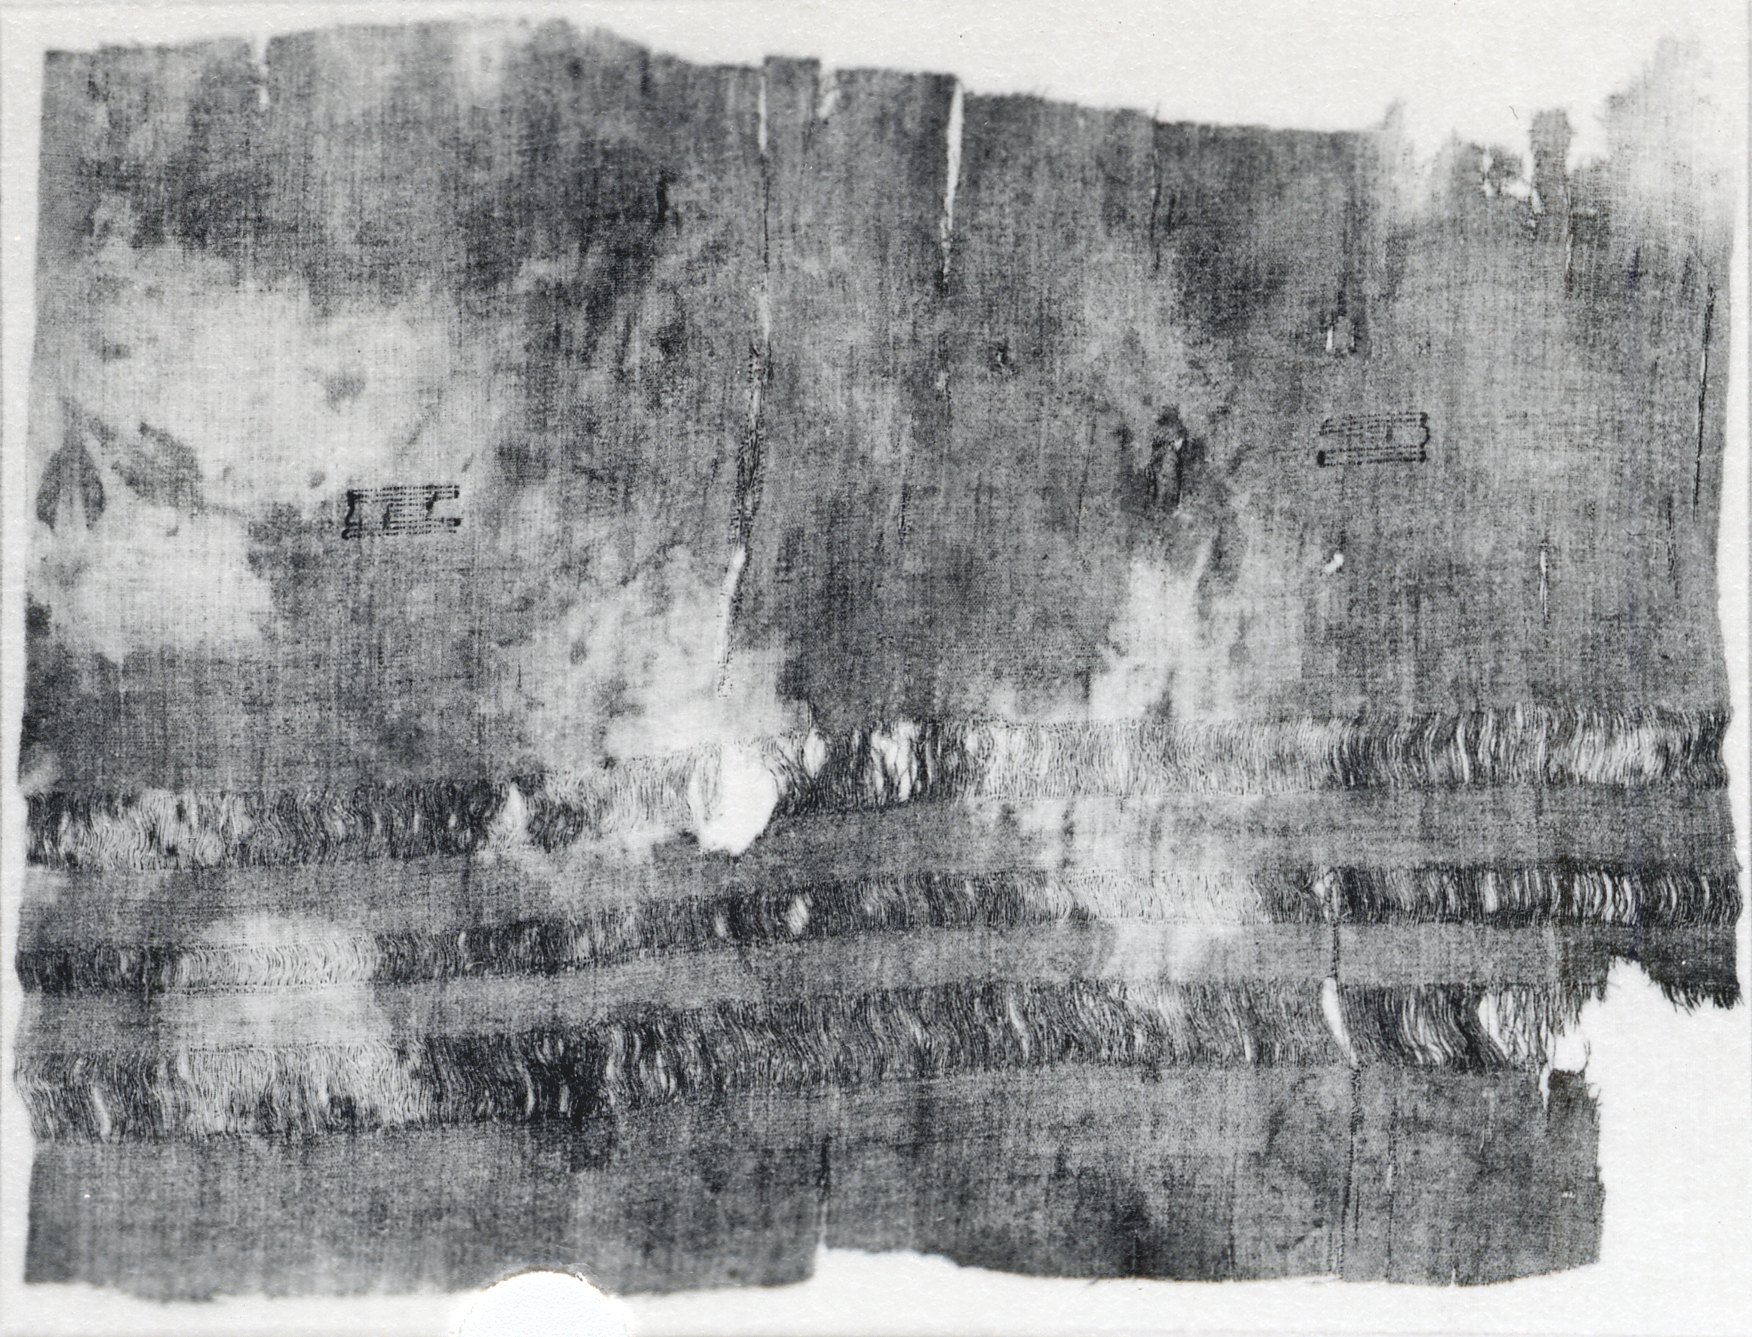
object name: fragment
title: Sheet Fragment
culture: coptic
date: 301-400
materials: linen, wool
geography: egypt